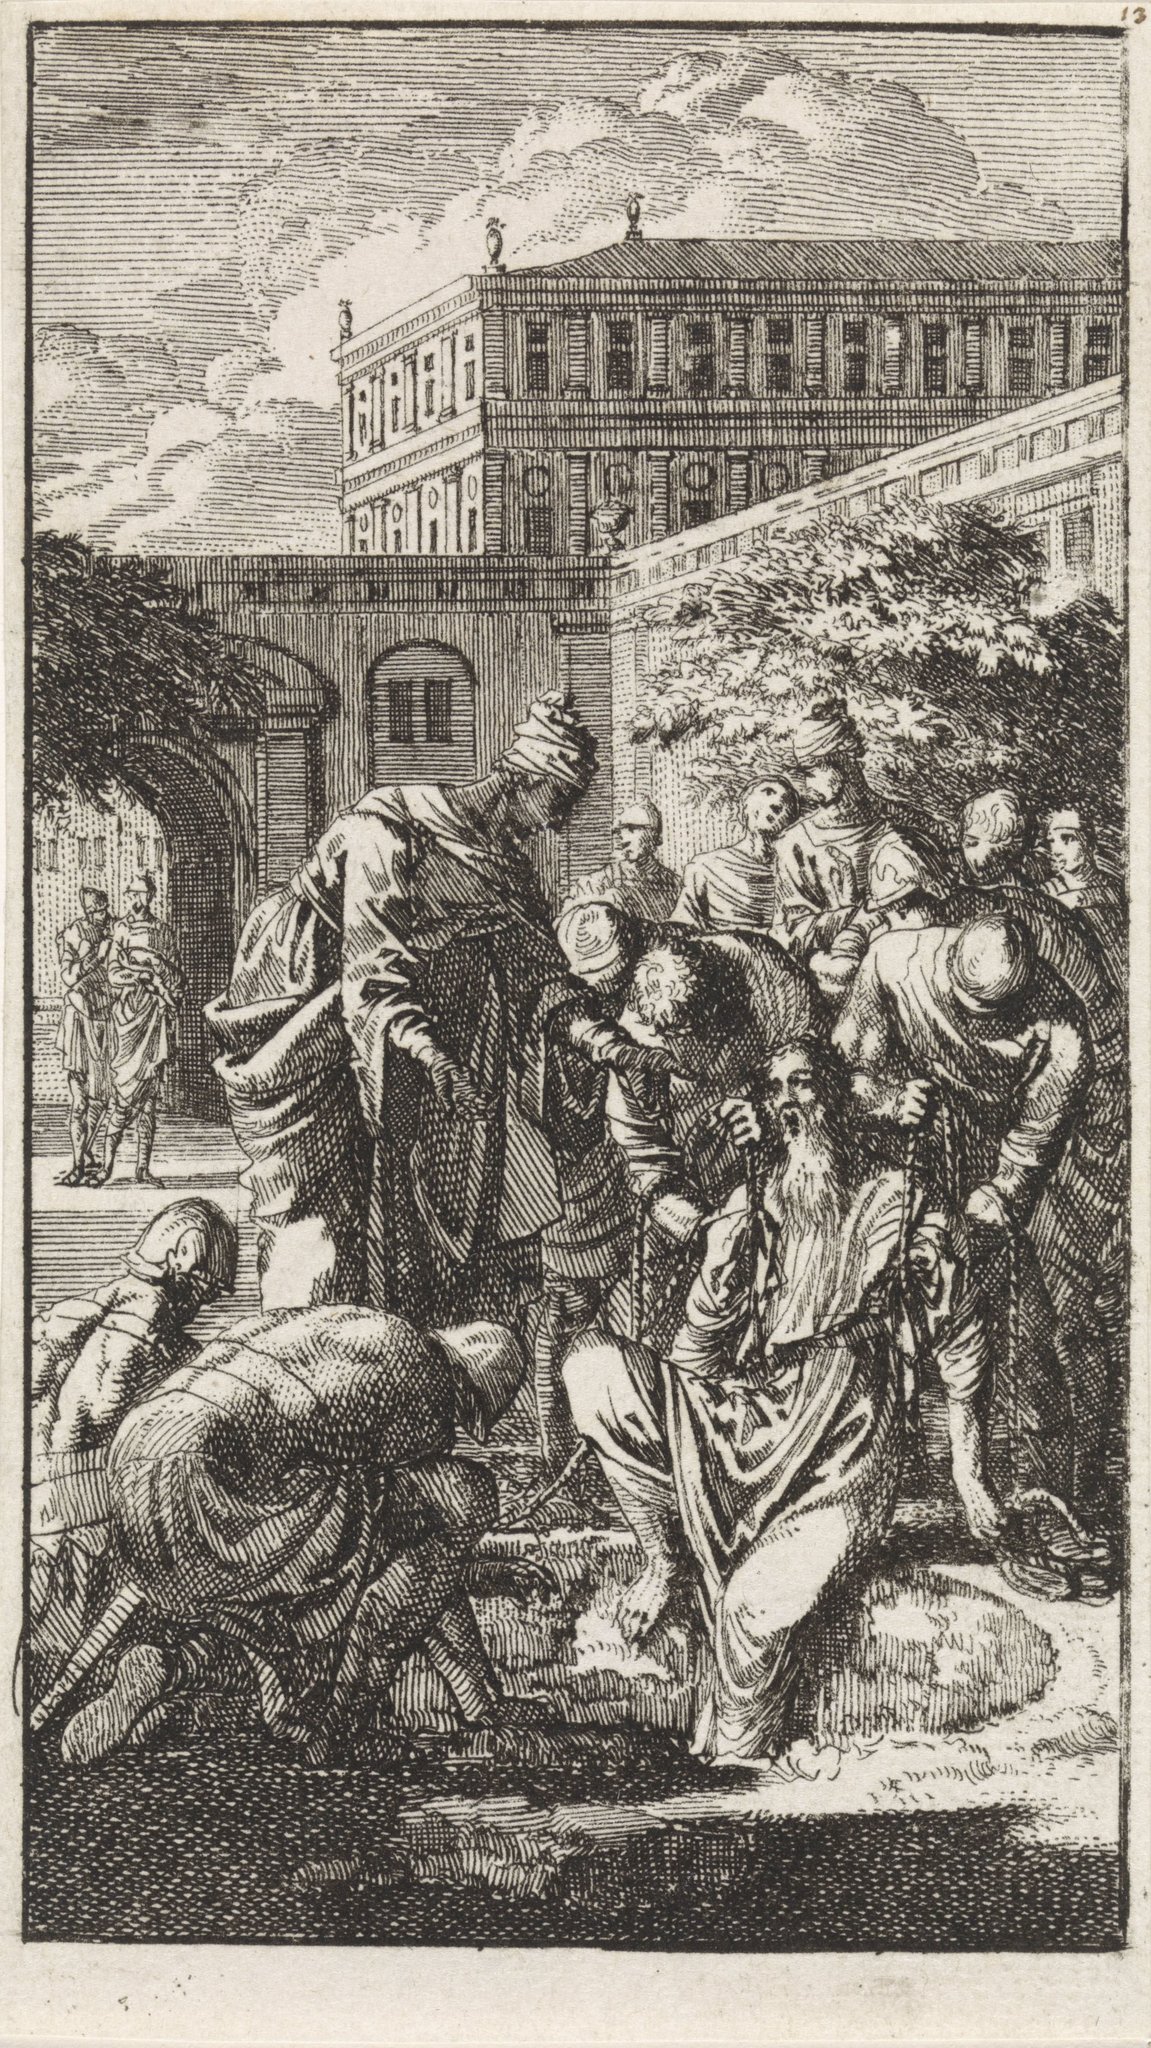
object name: print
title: Jeremia uit de kuil getrokken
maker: jan luyken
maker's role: draughtsman, print maker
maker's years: 1649-1712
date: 1712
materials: paper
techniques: etching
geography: amsterdam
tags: jeremiah's imprisonment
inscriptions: collector's mark: Lugt 2228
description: Proefdruk van illustratie voor: Luyken, Jan. Bybel printen. Amsterdam: Pieter Arentsz. II (wed.) en Cornelis van der Sys, 1712, p. 15.